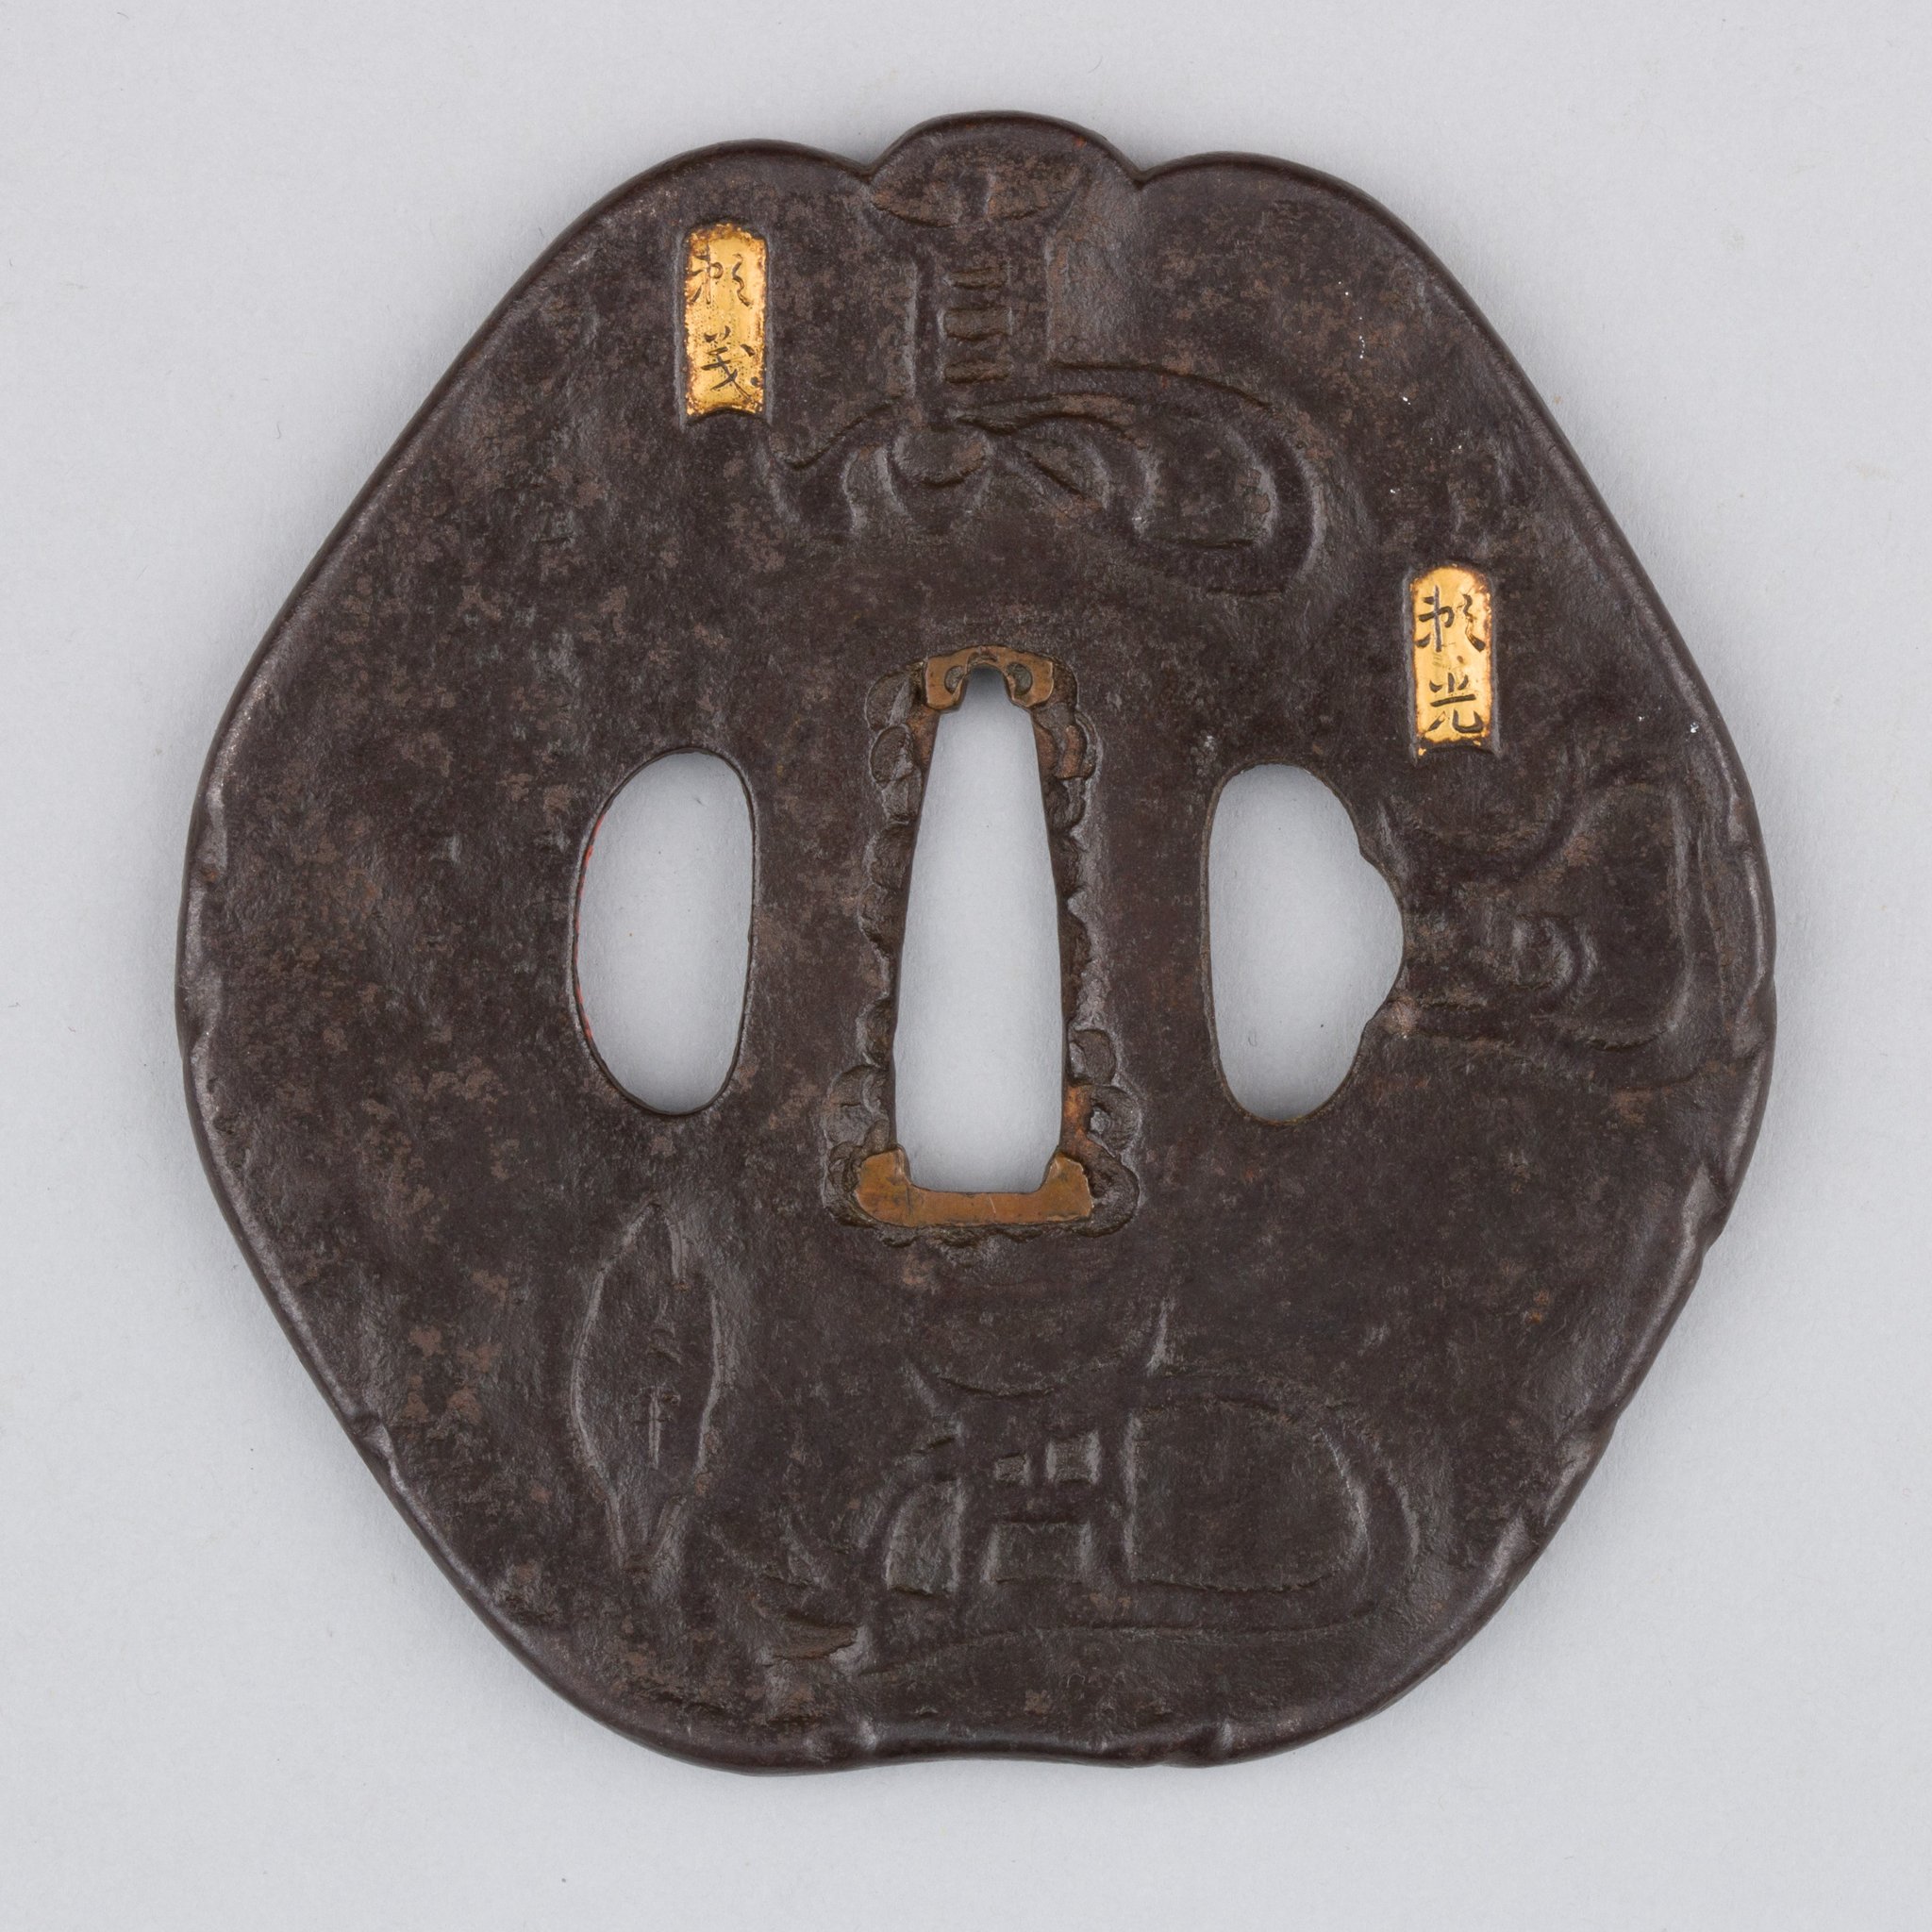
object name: sword guard tsuba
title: Sword Guard (Tsuba)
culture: japanese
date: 1601-1800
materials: copper, gold, iron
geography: japan